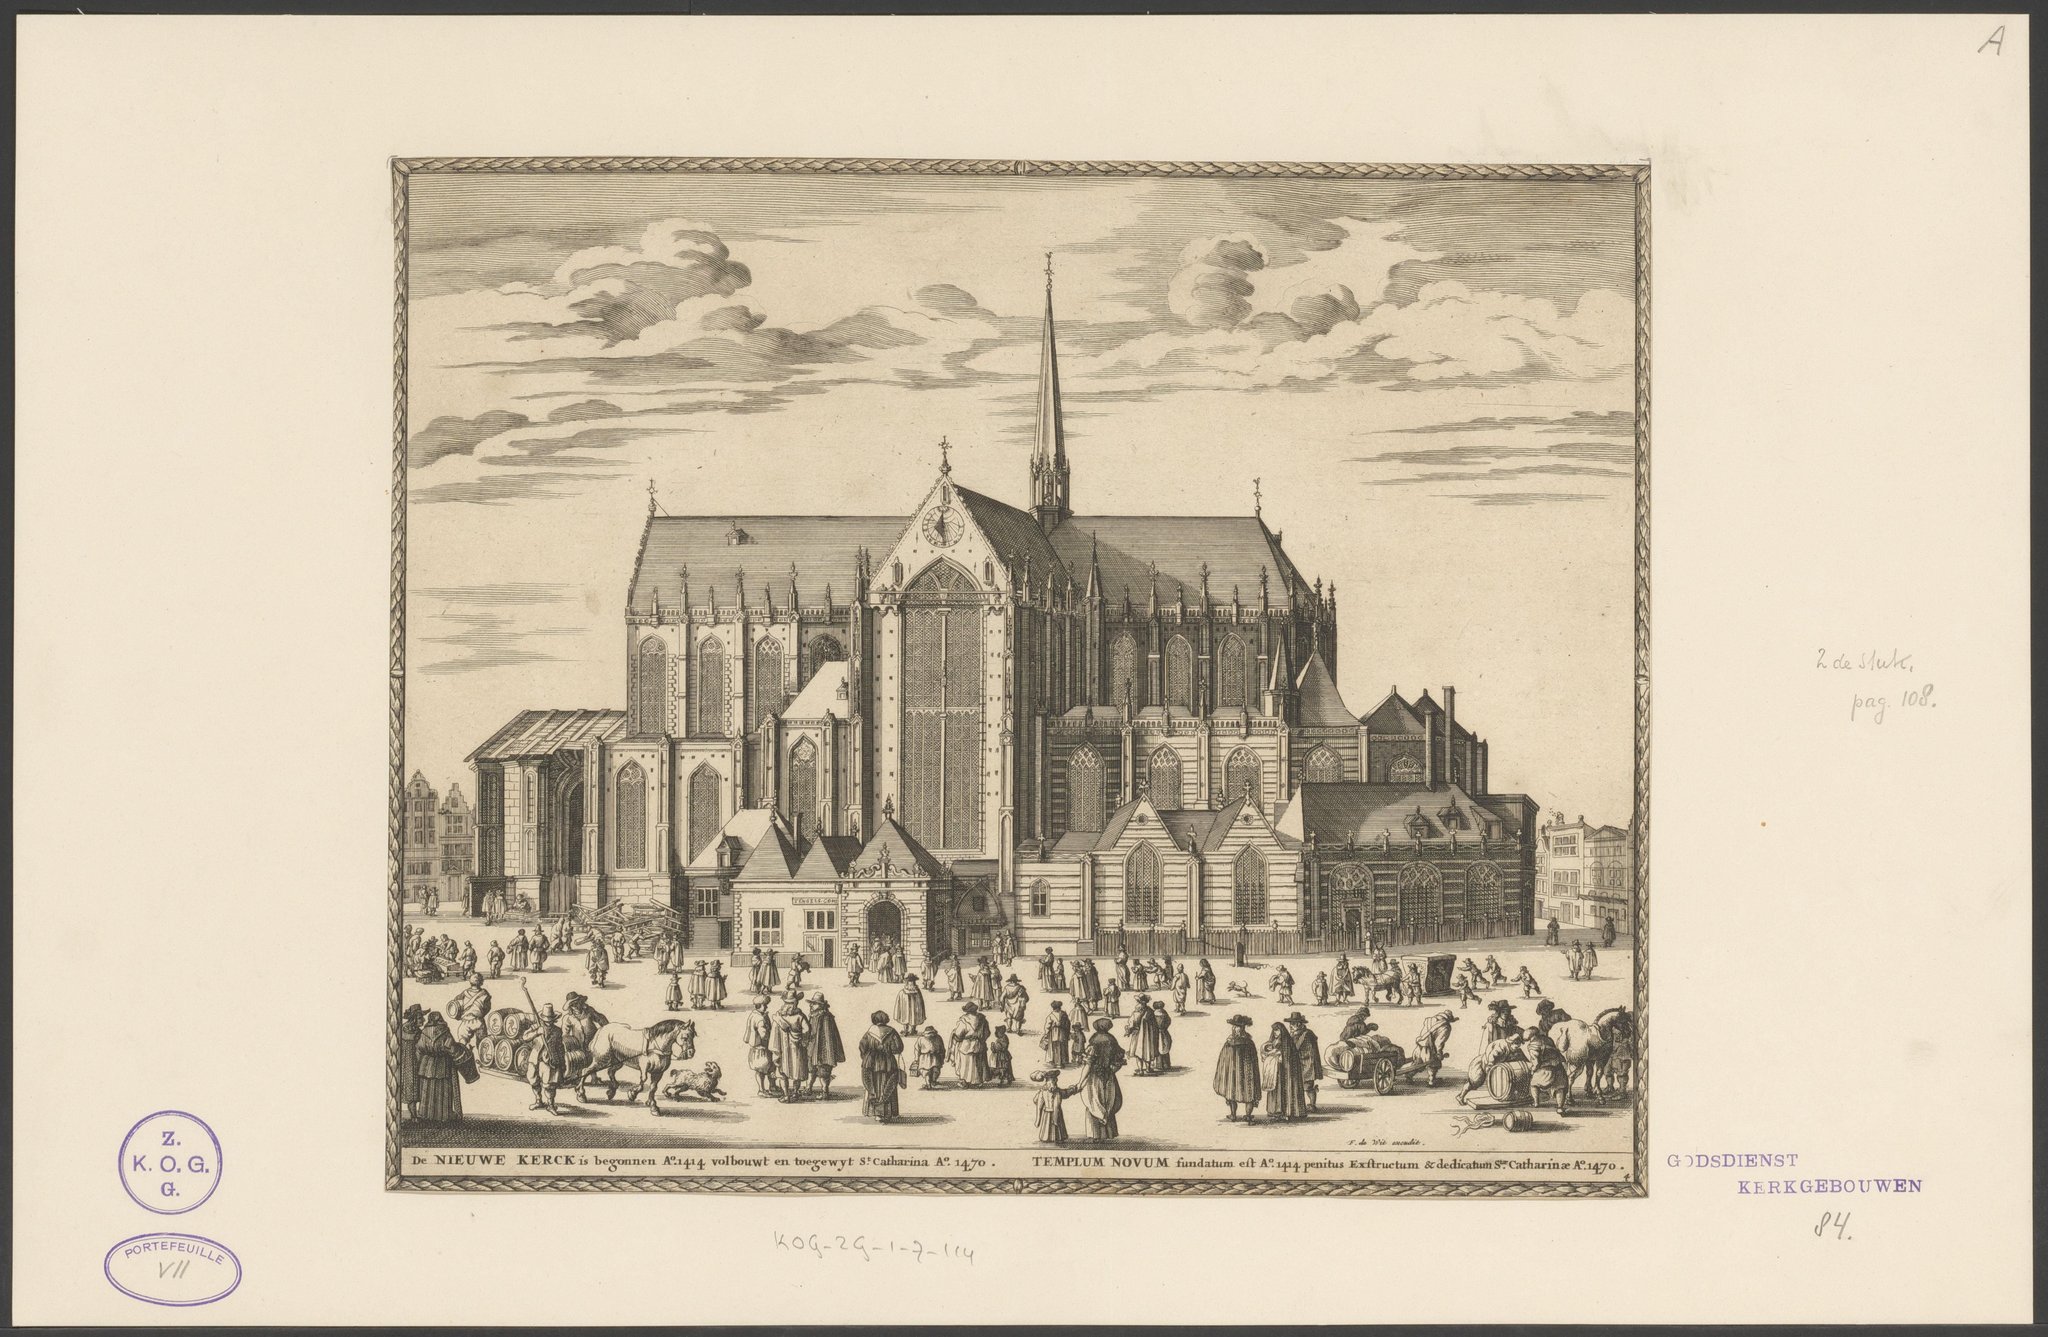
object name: book illustration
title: Gezicht op de Nieuwe Kerk te Amsterdam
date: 1662-1728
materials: paper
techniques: engraving, etching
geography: amsterdam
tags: church (exterior), city-view, and landscape with man-made constructions (+ city(-scape) with figures, staffage)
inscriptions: collector's mark: Lugt 1641, stamp, stamp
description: Prent mogelijk uit: La celebre ville d'Amsterdam, representée dans toute sa splendeur et sa magnificence (...) / De heerlykheid der wyd-vermaerde stad Amsterdam (…). Leiden: Pieter van der Aa, s.a. En in: Aa, Pieter van der. Europa. Leiden: Pieter van der Aa, s.a. [ca. 1715]. En in: Aa, Pieter van der. La galerie agreable du monde (...). 66 dln. Leiden: Pieter van der Aa, 1728, dl. 17.